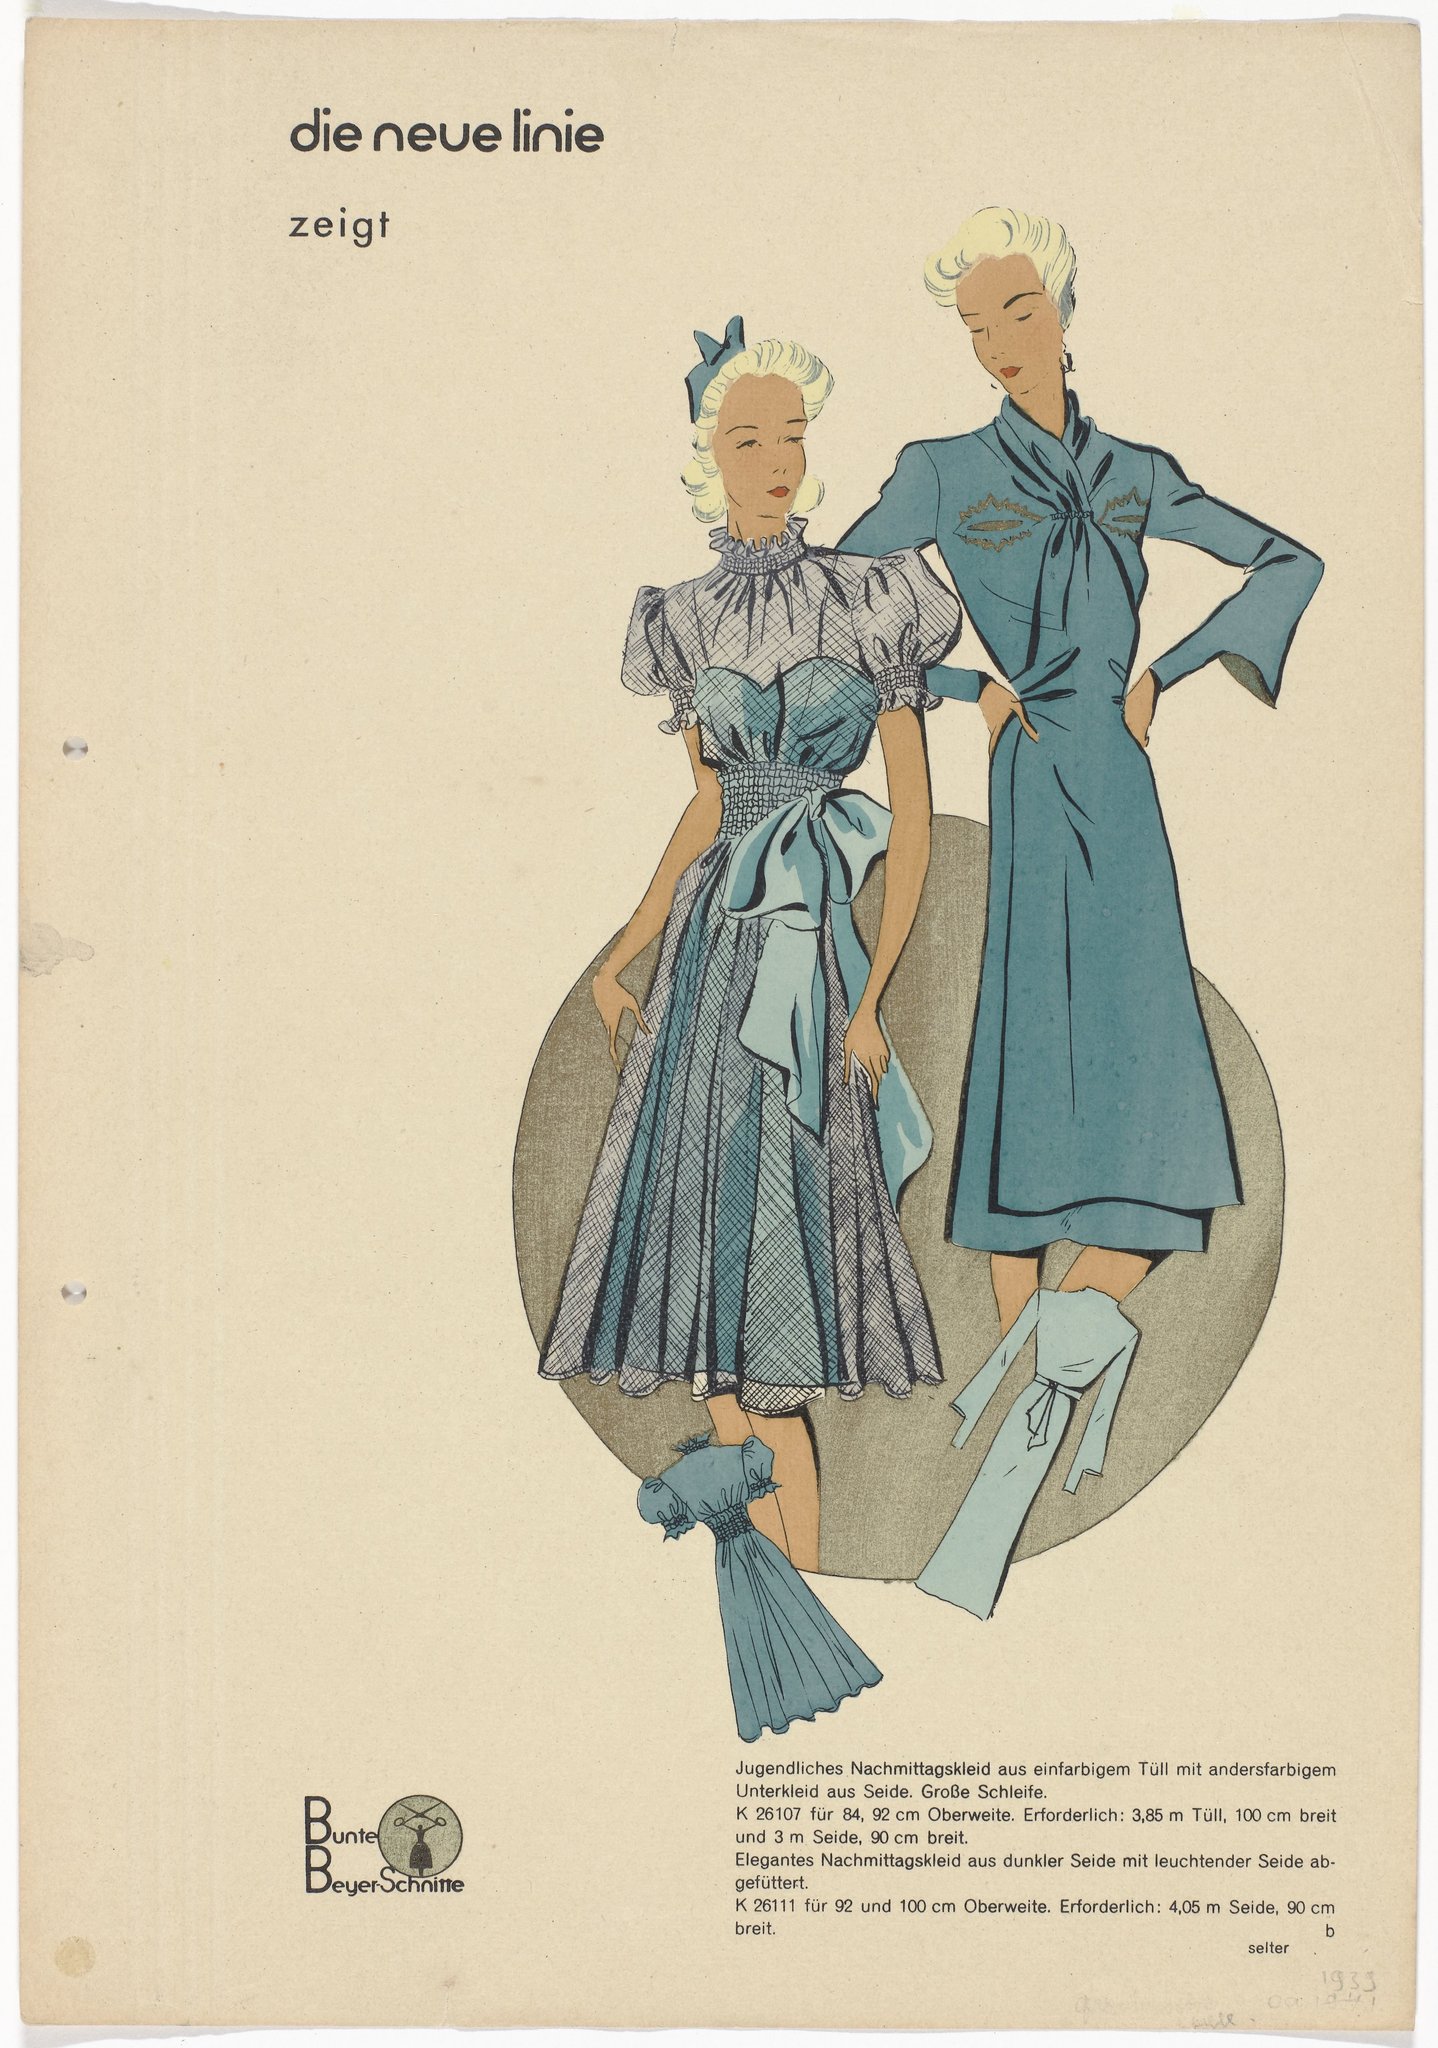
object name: fashion print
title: Bunte Beyer-Schnitte, die neue linie, 1939 : Jugendliches Nachmittagskleid (...)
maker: Anonymous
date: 1939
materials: paper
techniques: engraving, hand coloring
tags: dress, gown (afternoon dress) (+ women's clothes), fashion plates, clothes, costume (+ women's clothes)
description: Middagjaponnen voor de jonge vrouw, 1939.